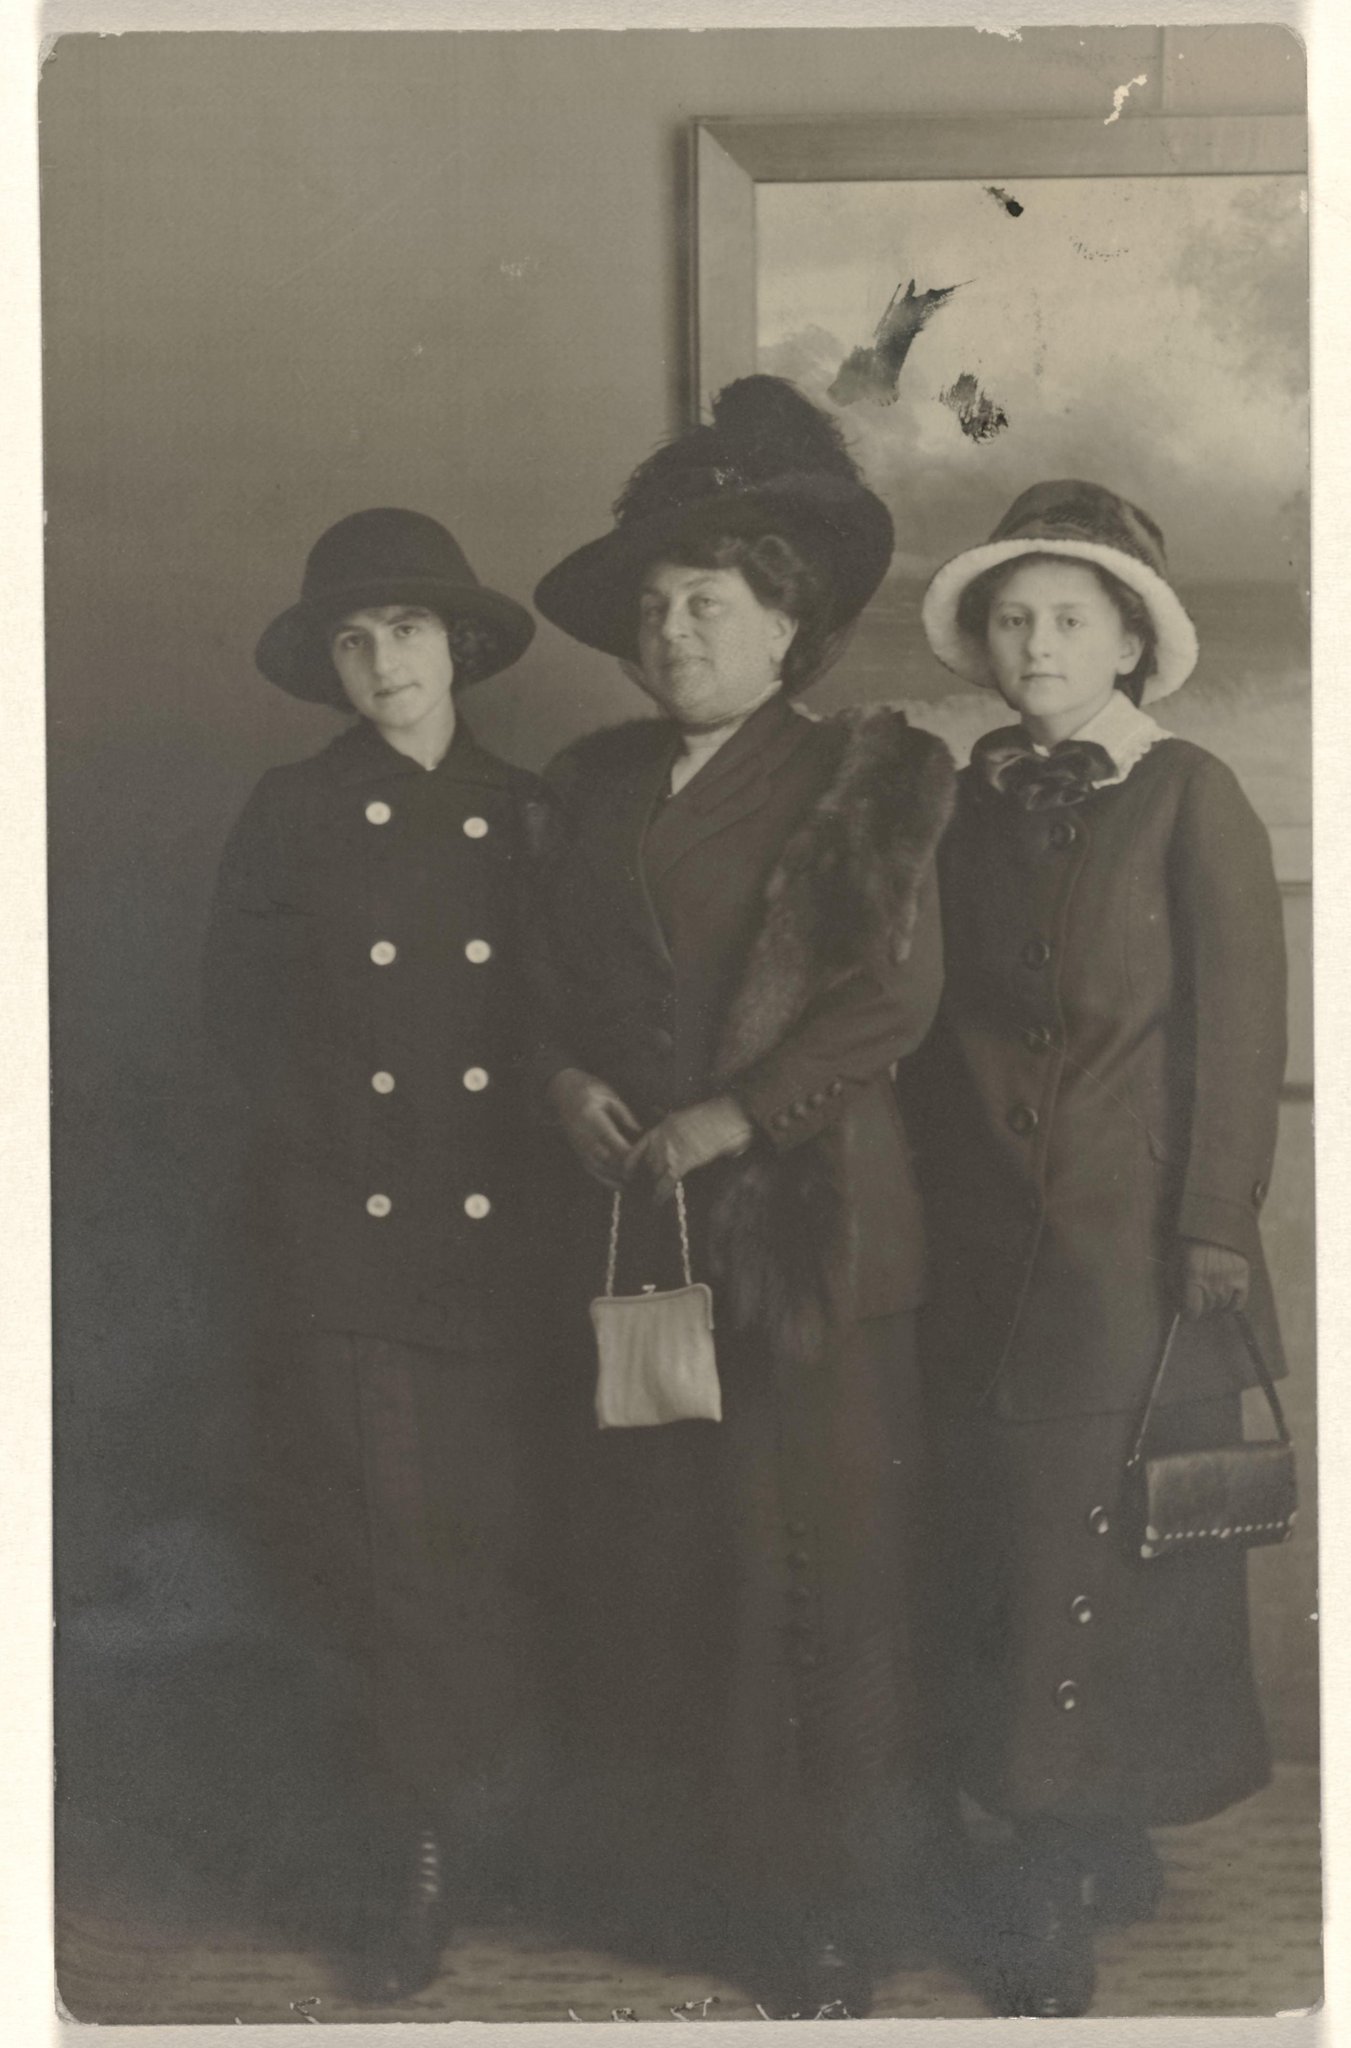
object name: photograph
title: Drie ongeidenificeerde vrouwen, 1880-1930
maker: Anonymous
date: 1880-1930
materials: photographic support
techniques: gelatin silver print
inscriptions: inscription: ‘Lieber Onkel Gern wären wir pünkt- lich zu Deinem Geburts- tag eingetroffen, aber wir waren noch nicht ganz so weit!_ Herzl. Grüsse v.U. Hernn Albert Levi Hechlingen Hohenzollern’